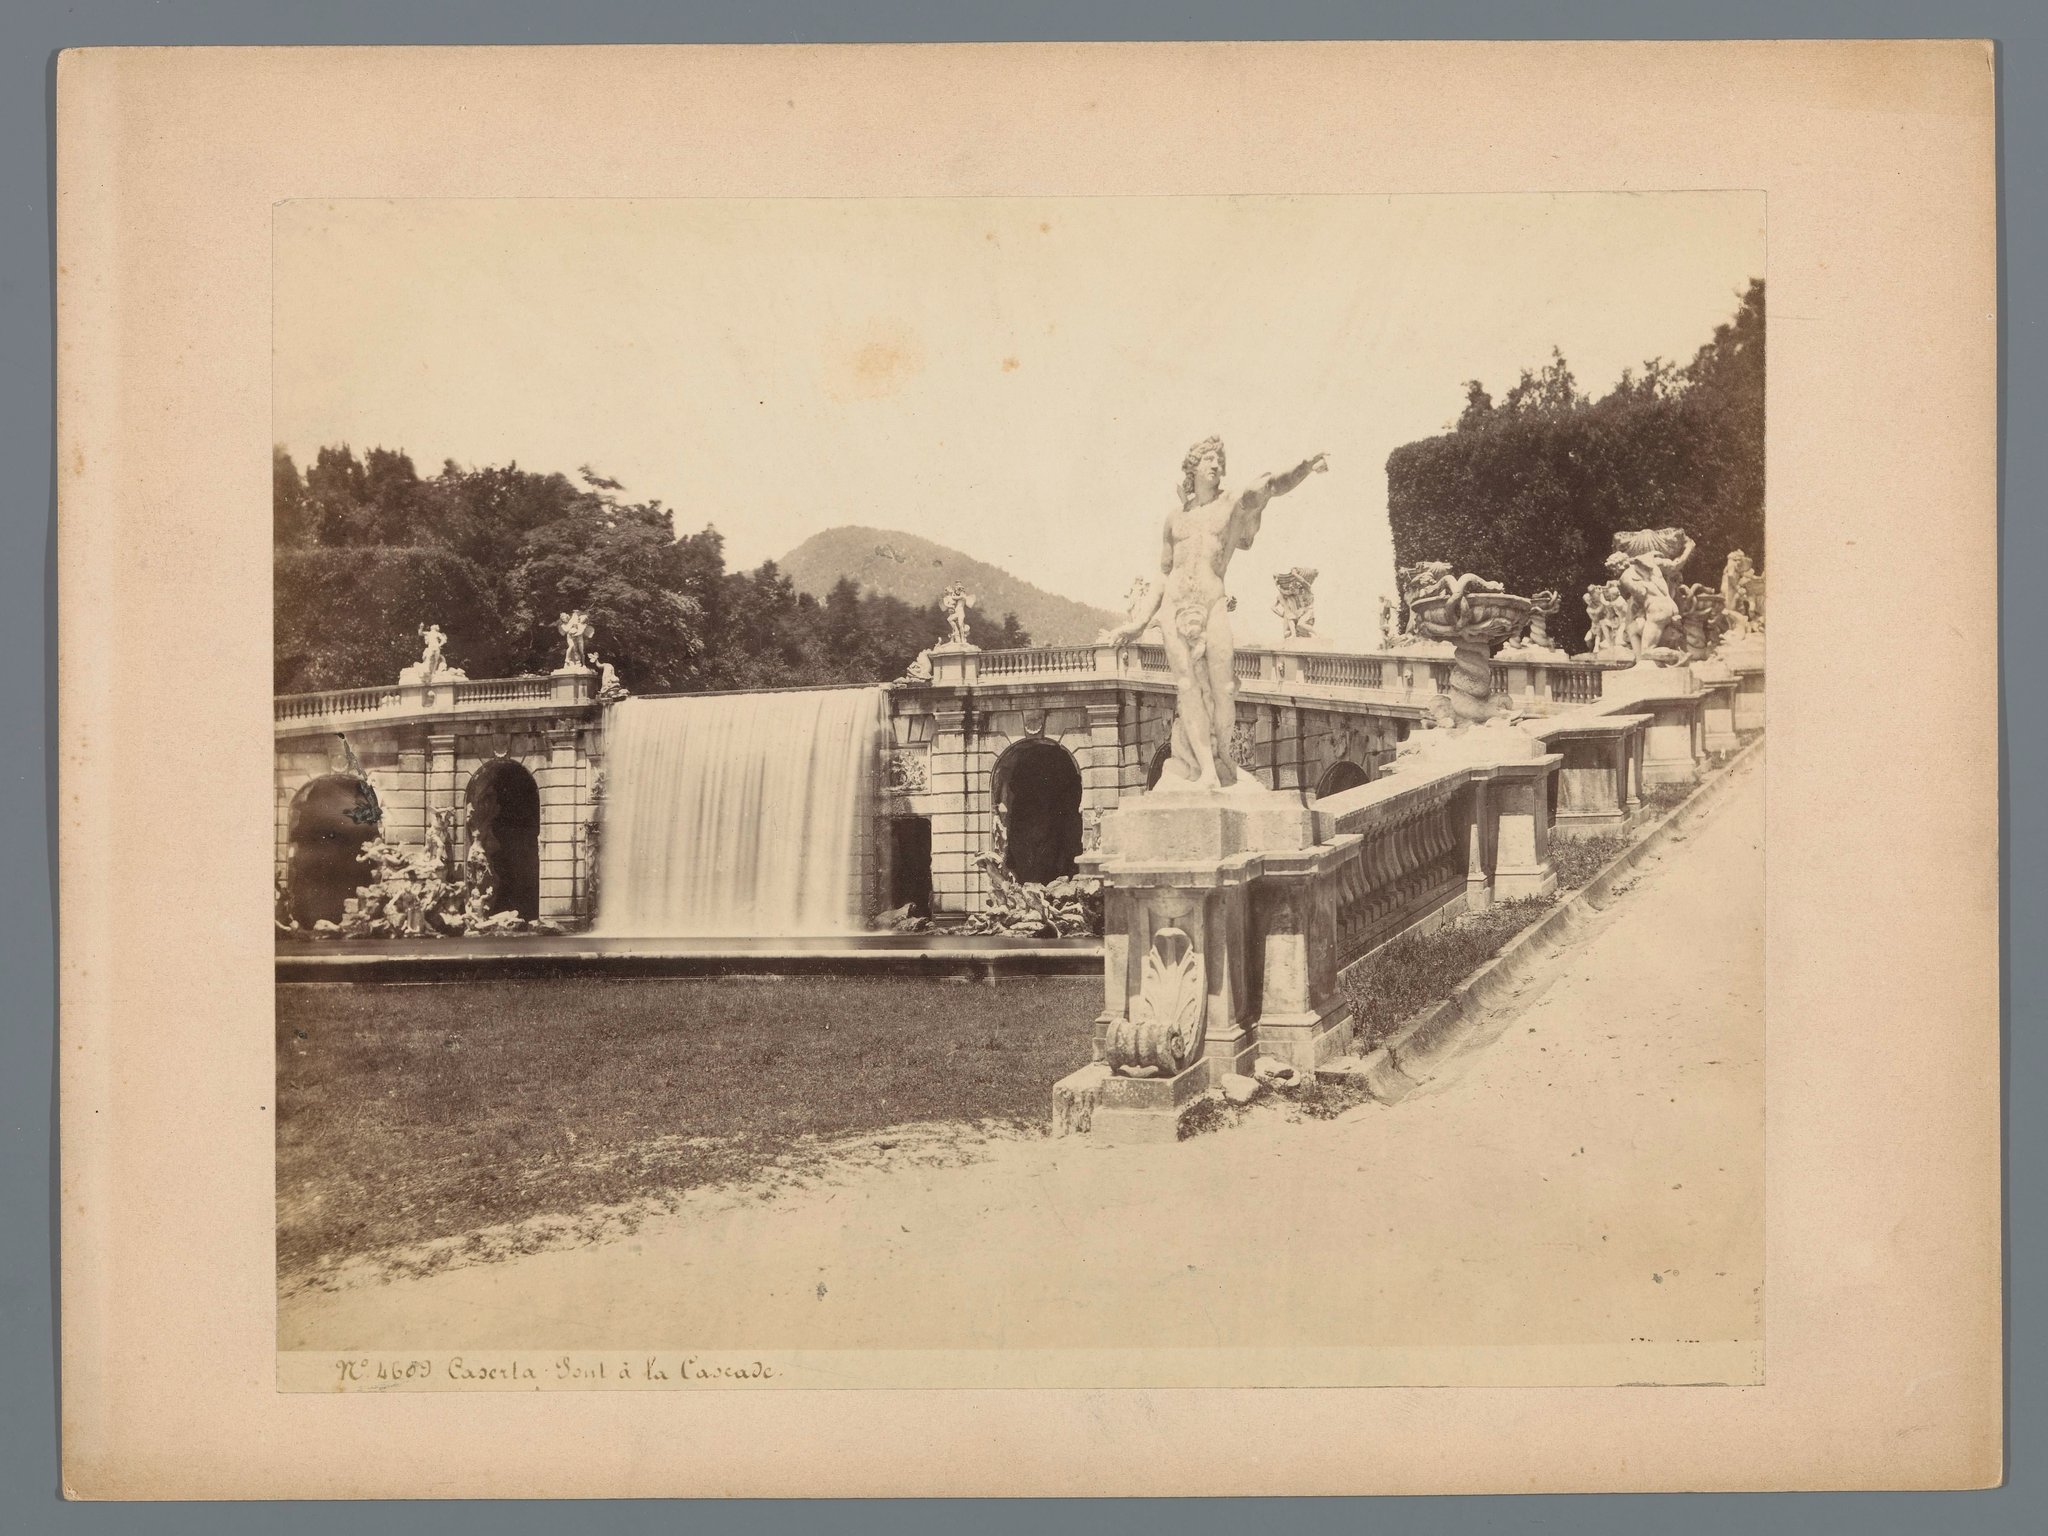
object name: photograph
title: Brug en waterval in de tuin van het paleis van Caserta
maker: Anonymous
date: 1875-1900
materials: cardboard, photographic support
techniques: albumen print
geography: caserta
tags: bridge, garden cascade, caserta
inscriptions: collector's mark: Lugt 3937, number: ‘No. 4609’